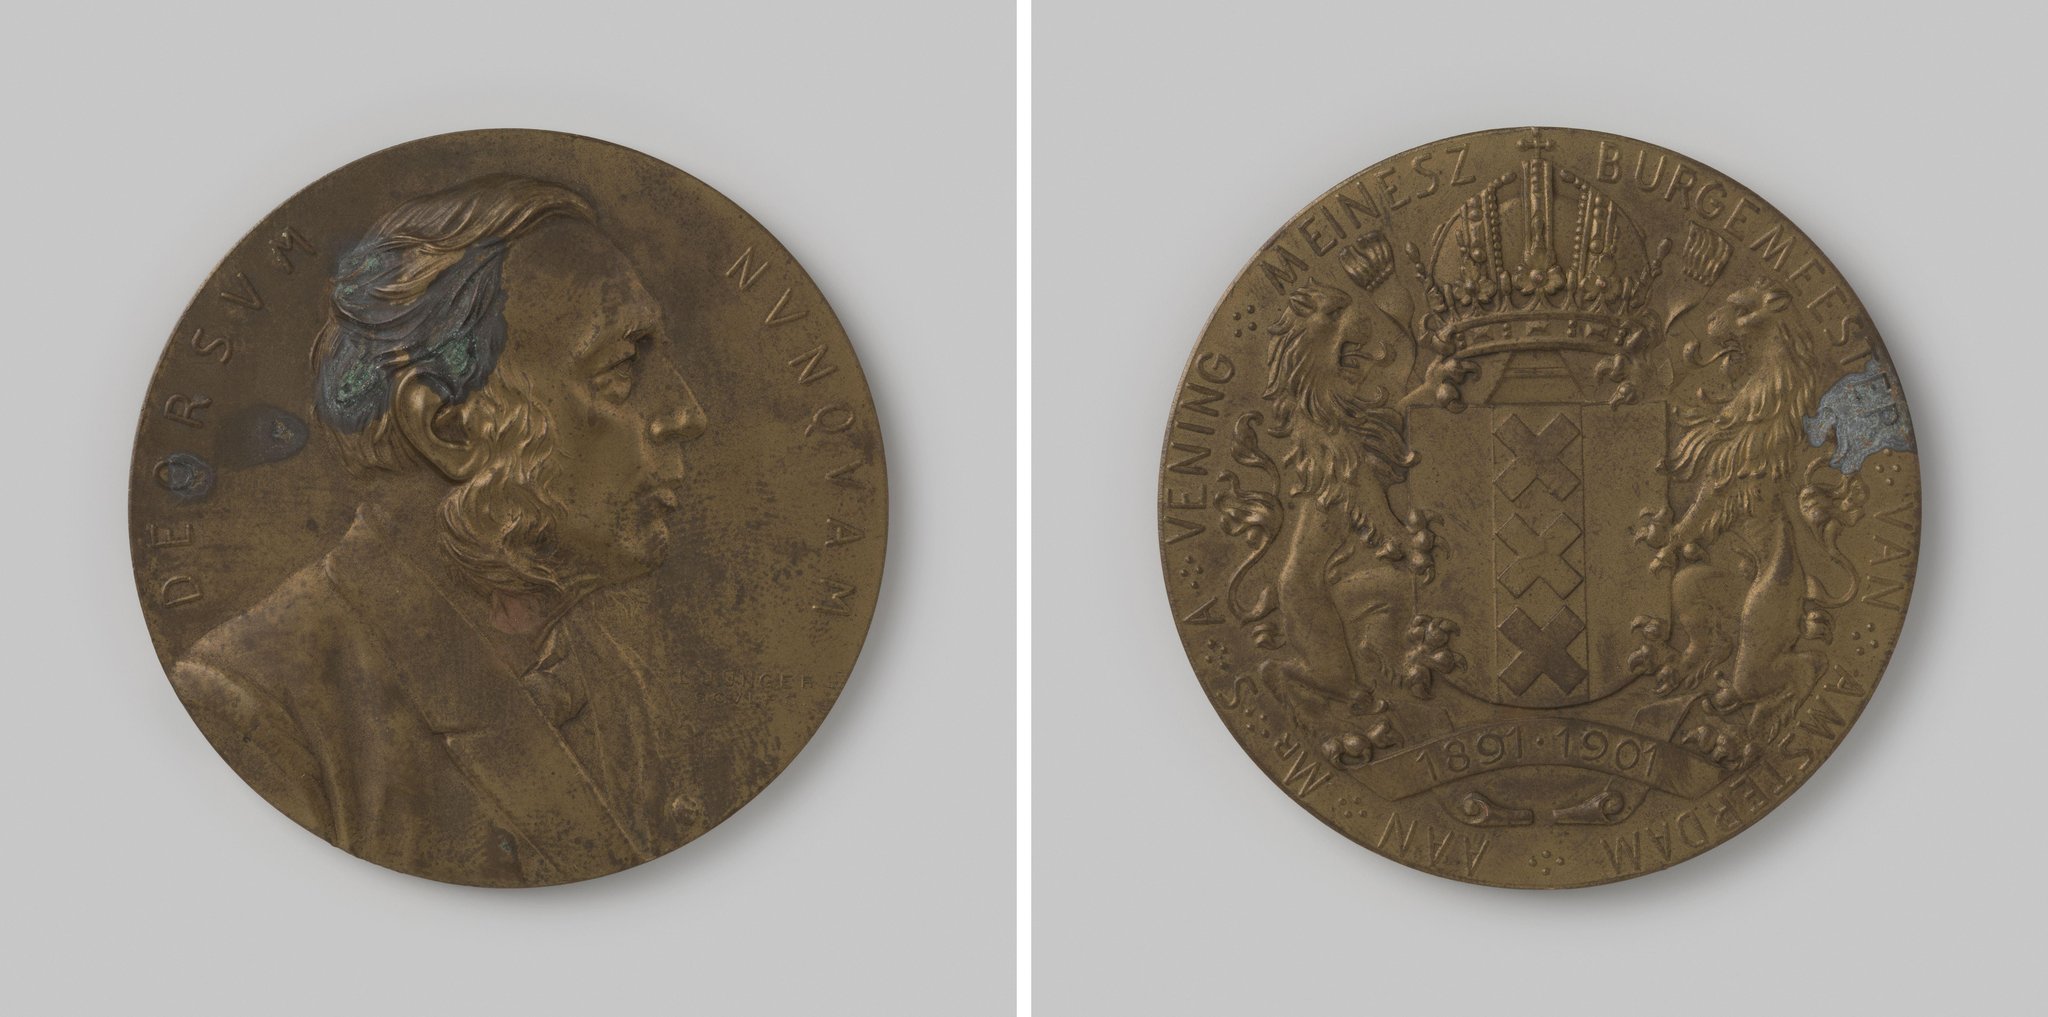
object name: history medal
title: Tienjarig jubileum van de burgemeester van Amsterdam Mr. S.A. Vening Meinesz 1901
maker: j.a.a. gerritsen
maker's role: manufacturer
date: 1901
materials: brass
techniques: striking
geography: amsterdam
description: Messing penning, op de voorzijde het borstbeeld van Vening Meinesz naar rechts met omschrift, op de keerzijde het gekroonde Amsterdamse wapenschild gedragen door leeuwen op een tekstlint, met omschift.